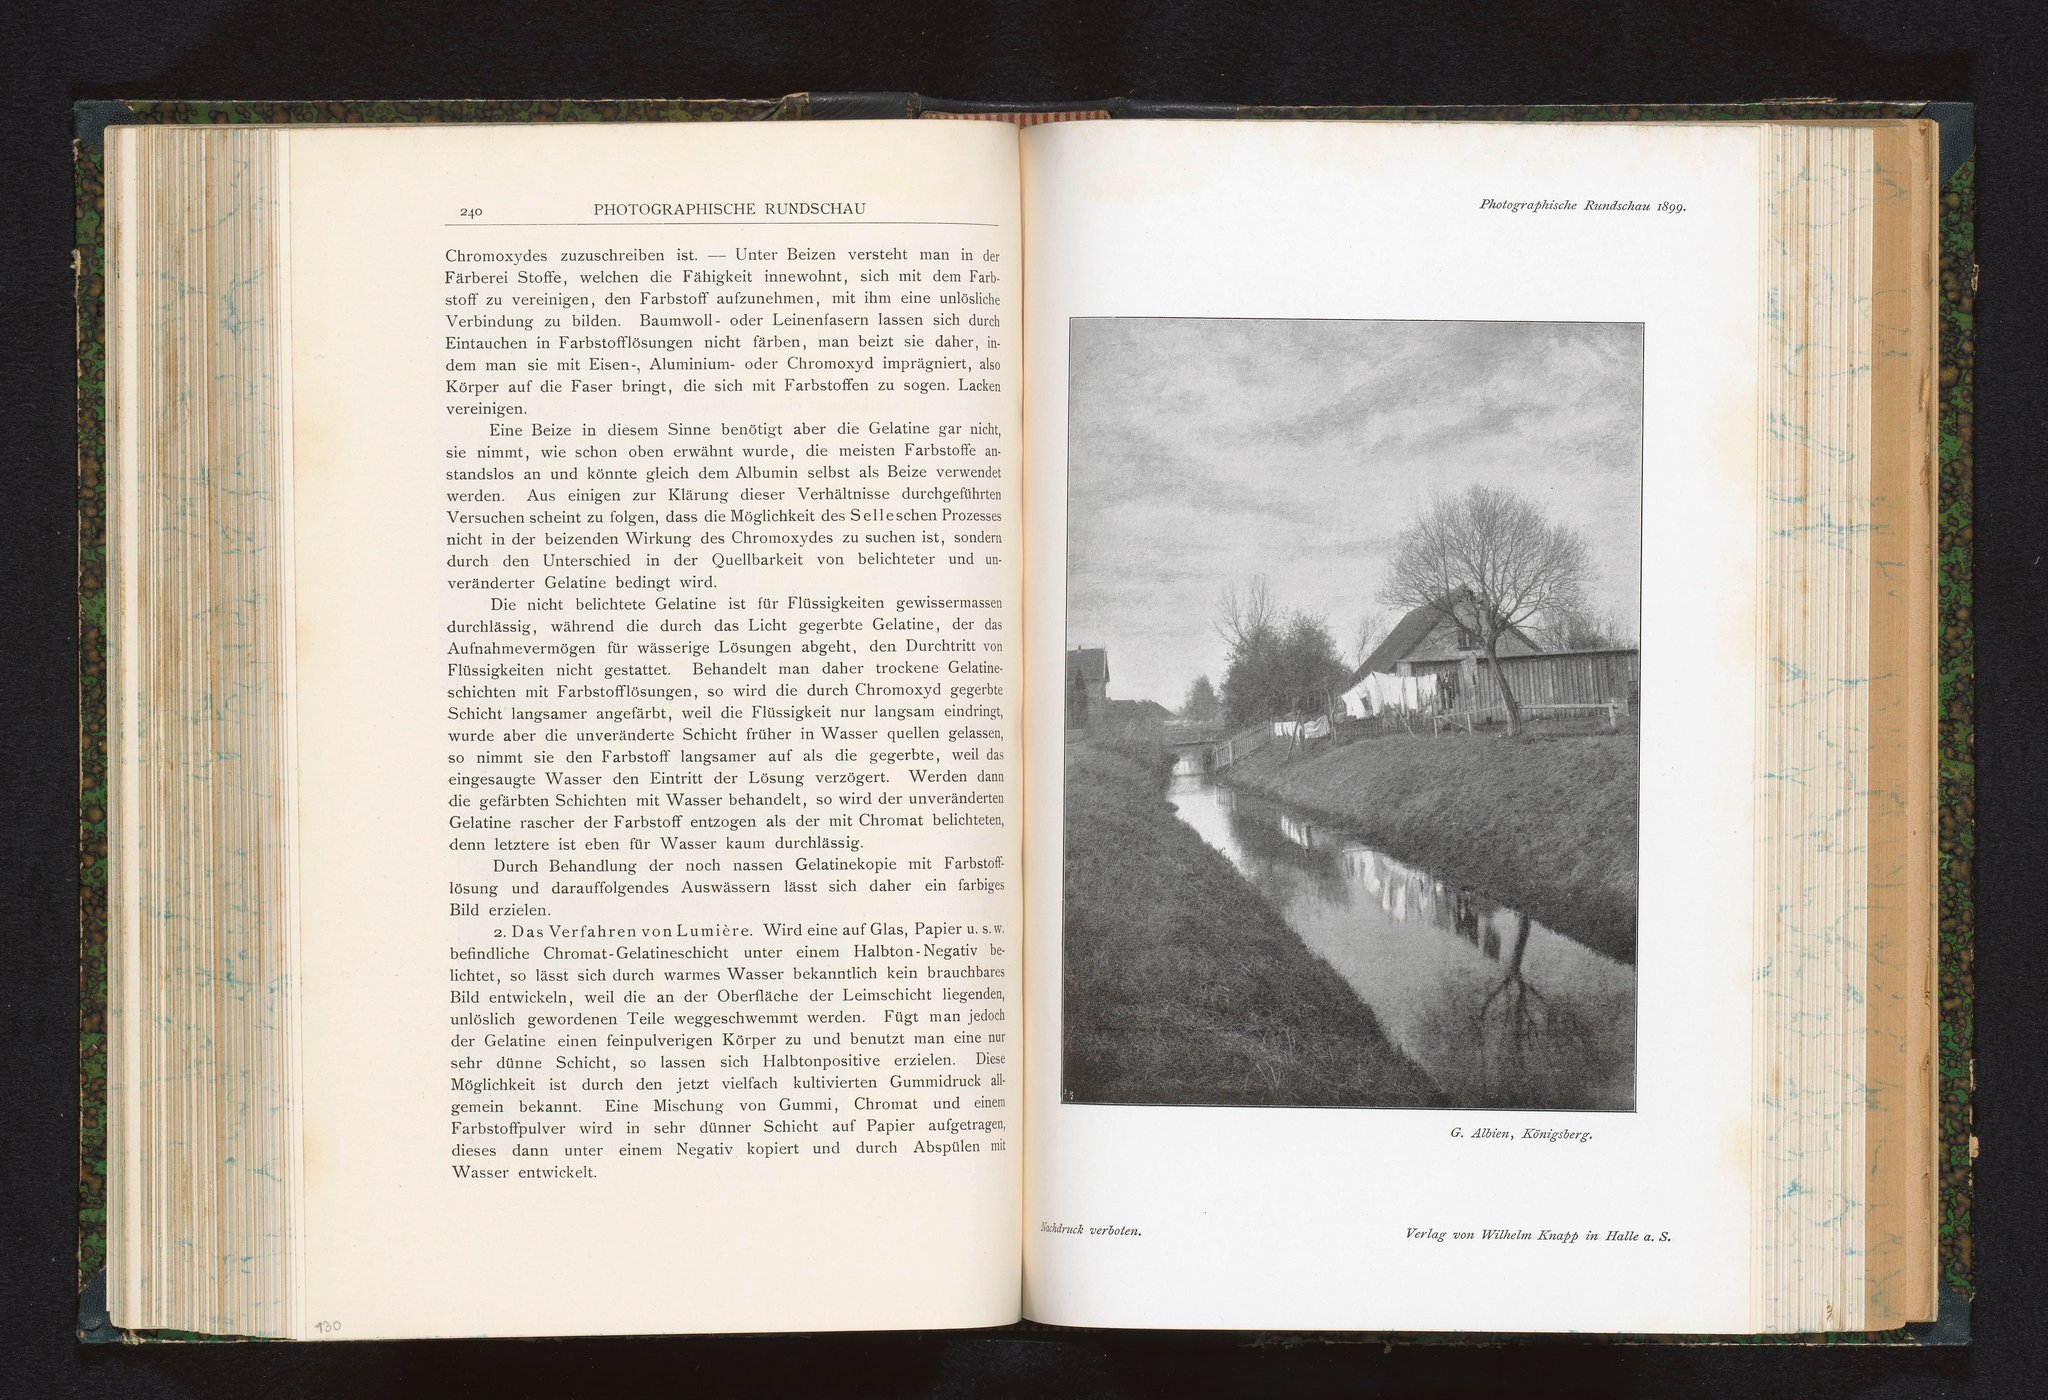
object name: page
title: Gezicht op een huis naast een sloot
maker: g. albien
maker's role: fotograaf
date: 1894-1899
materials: paper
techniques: autotype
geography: berlin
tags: rural housing, e.g. country-house, villa, cottage, small canal, ditch